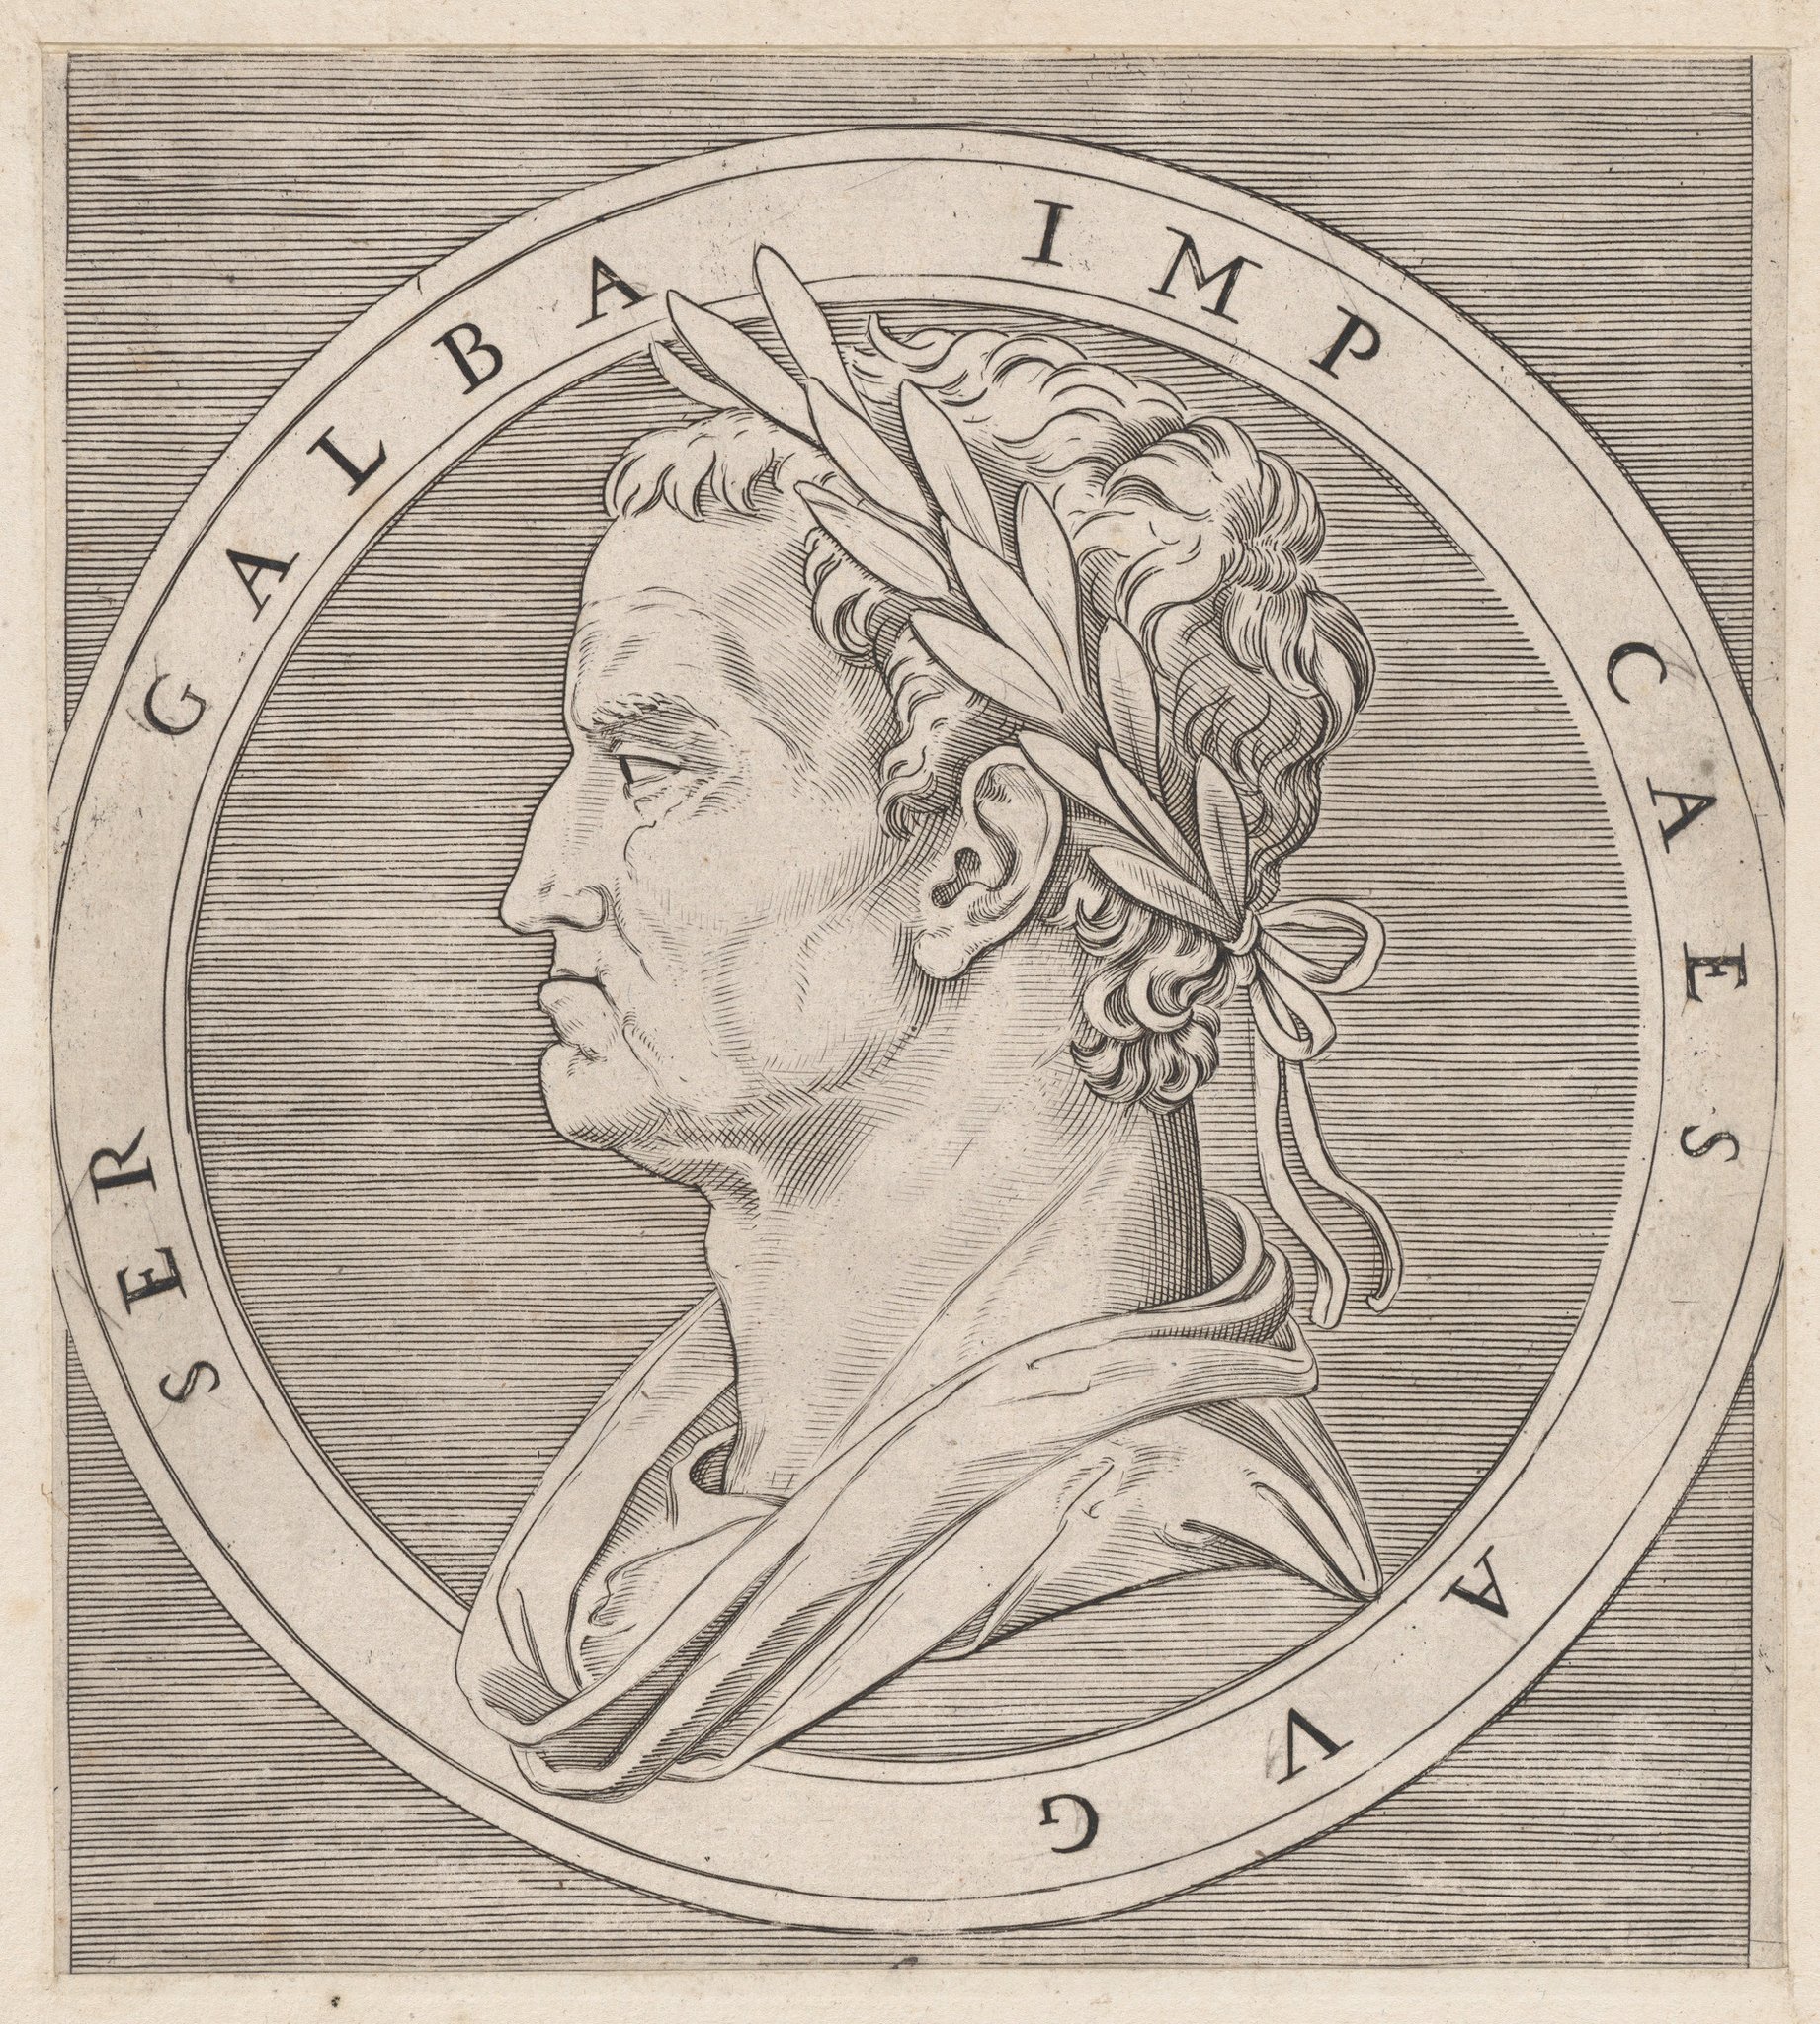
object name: print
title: Galba, from The Twelve Caesars, from "Speculum Romanae Magnificentiae"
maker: marcantonio raimondi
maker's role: artist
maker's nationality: italian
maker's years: 1475-1534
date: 1500-1534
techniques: engraving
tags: men,profiles